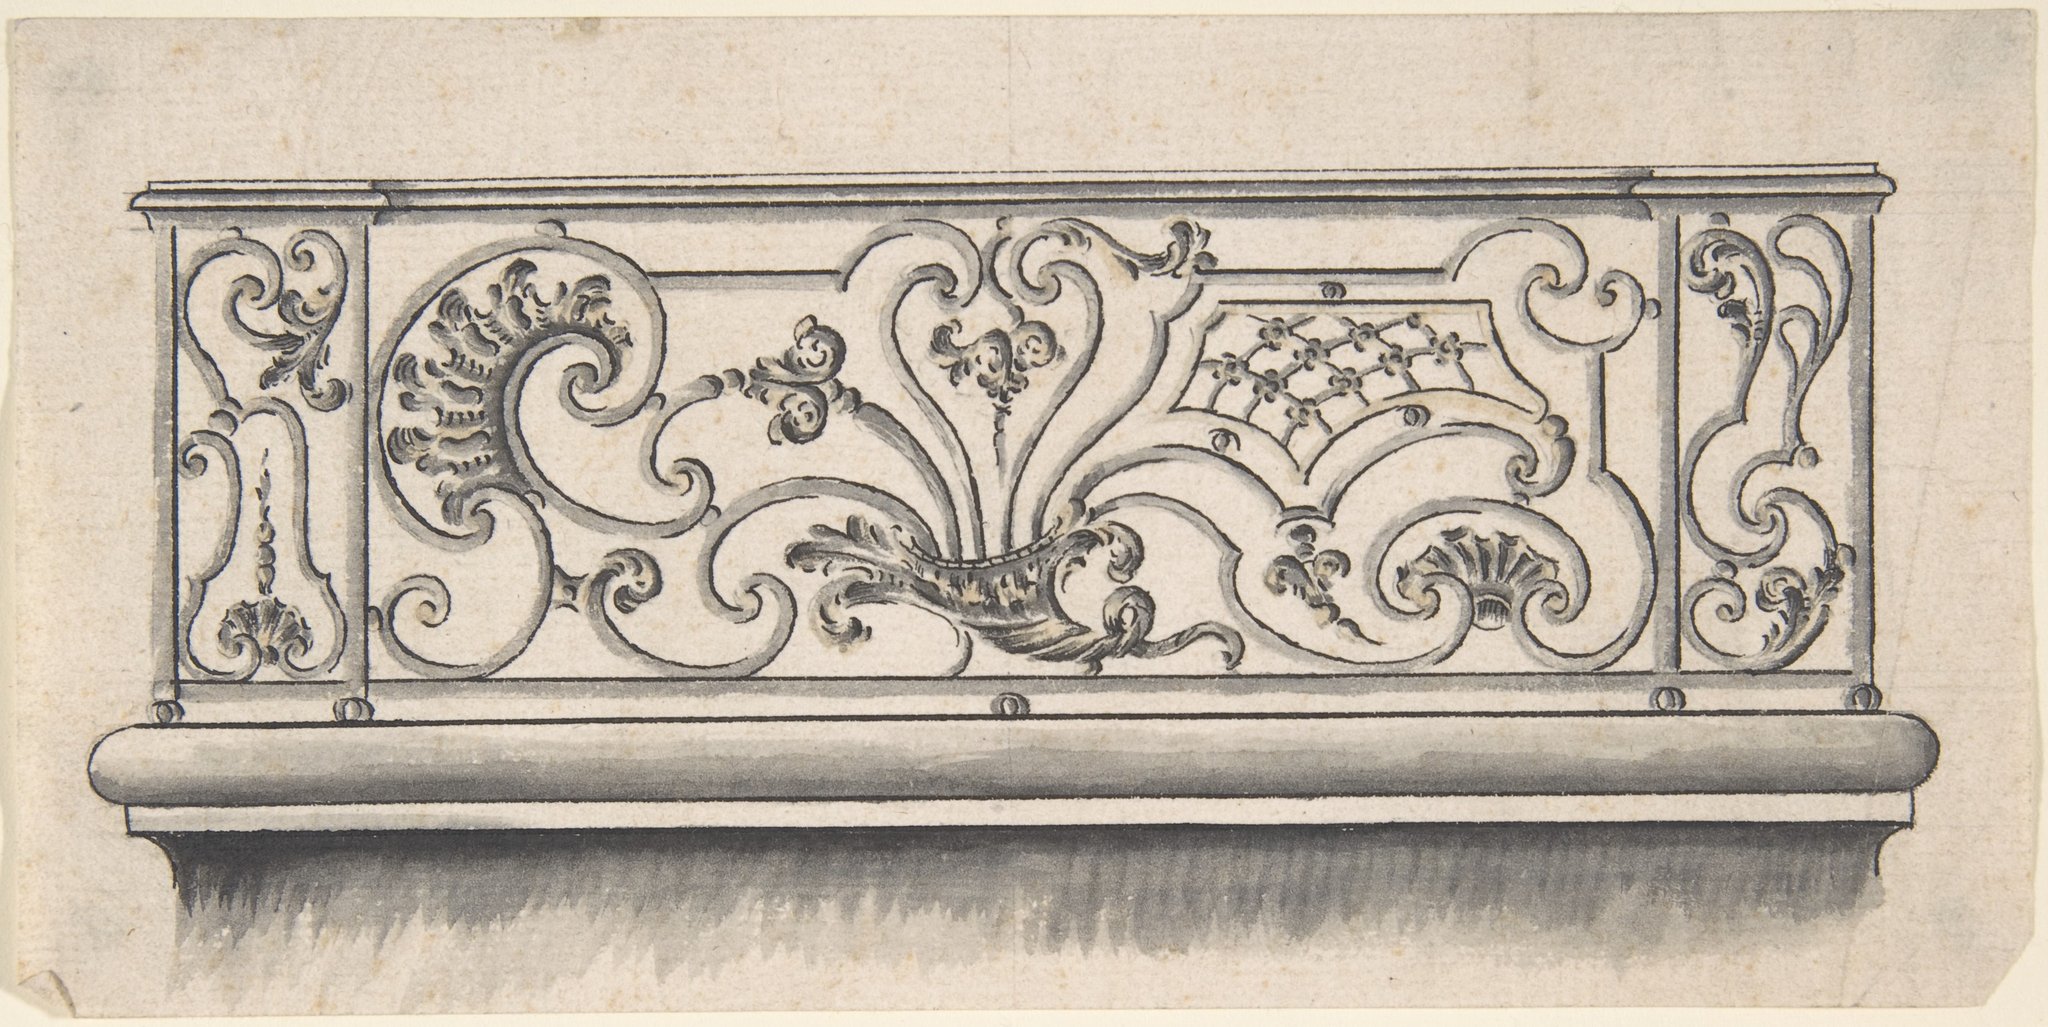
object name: drawing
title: Design for iron work balcony, with alternate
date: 1701-1800